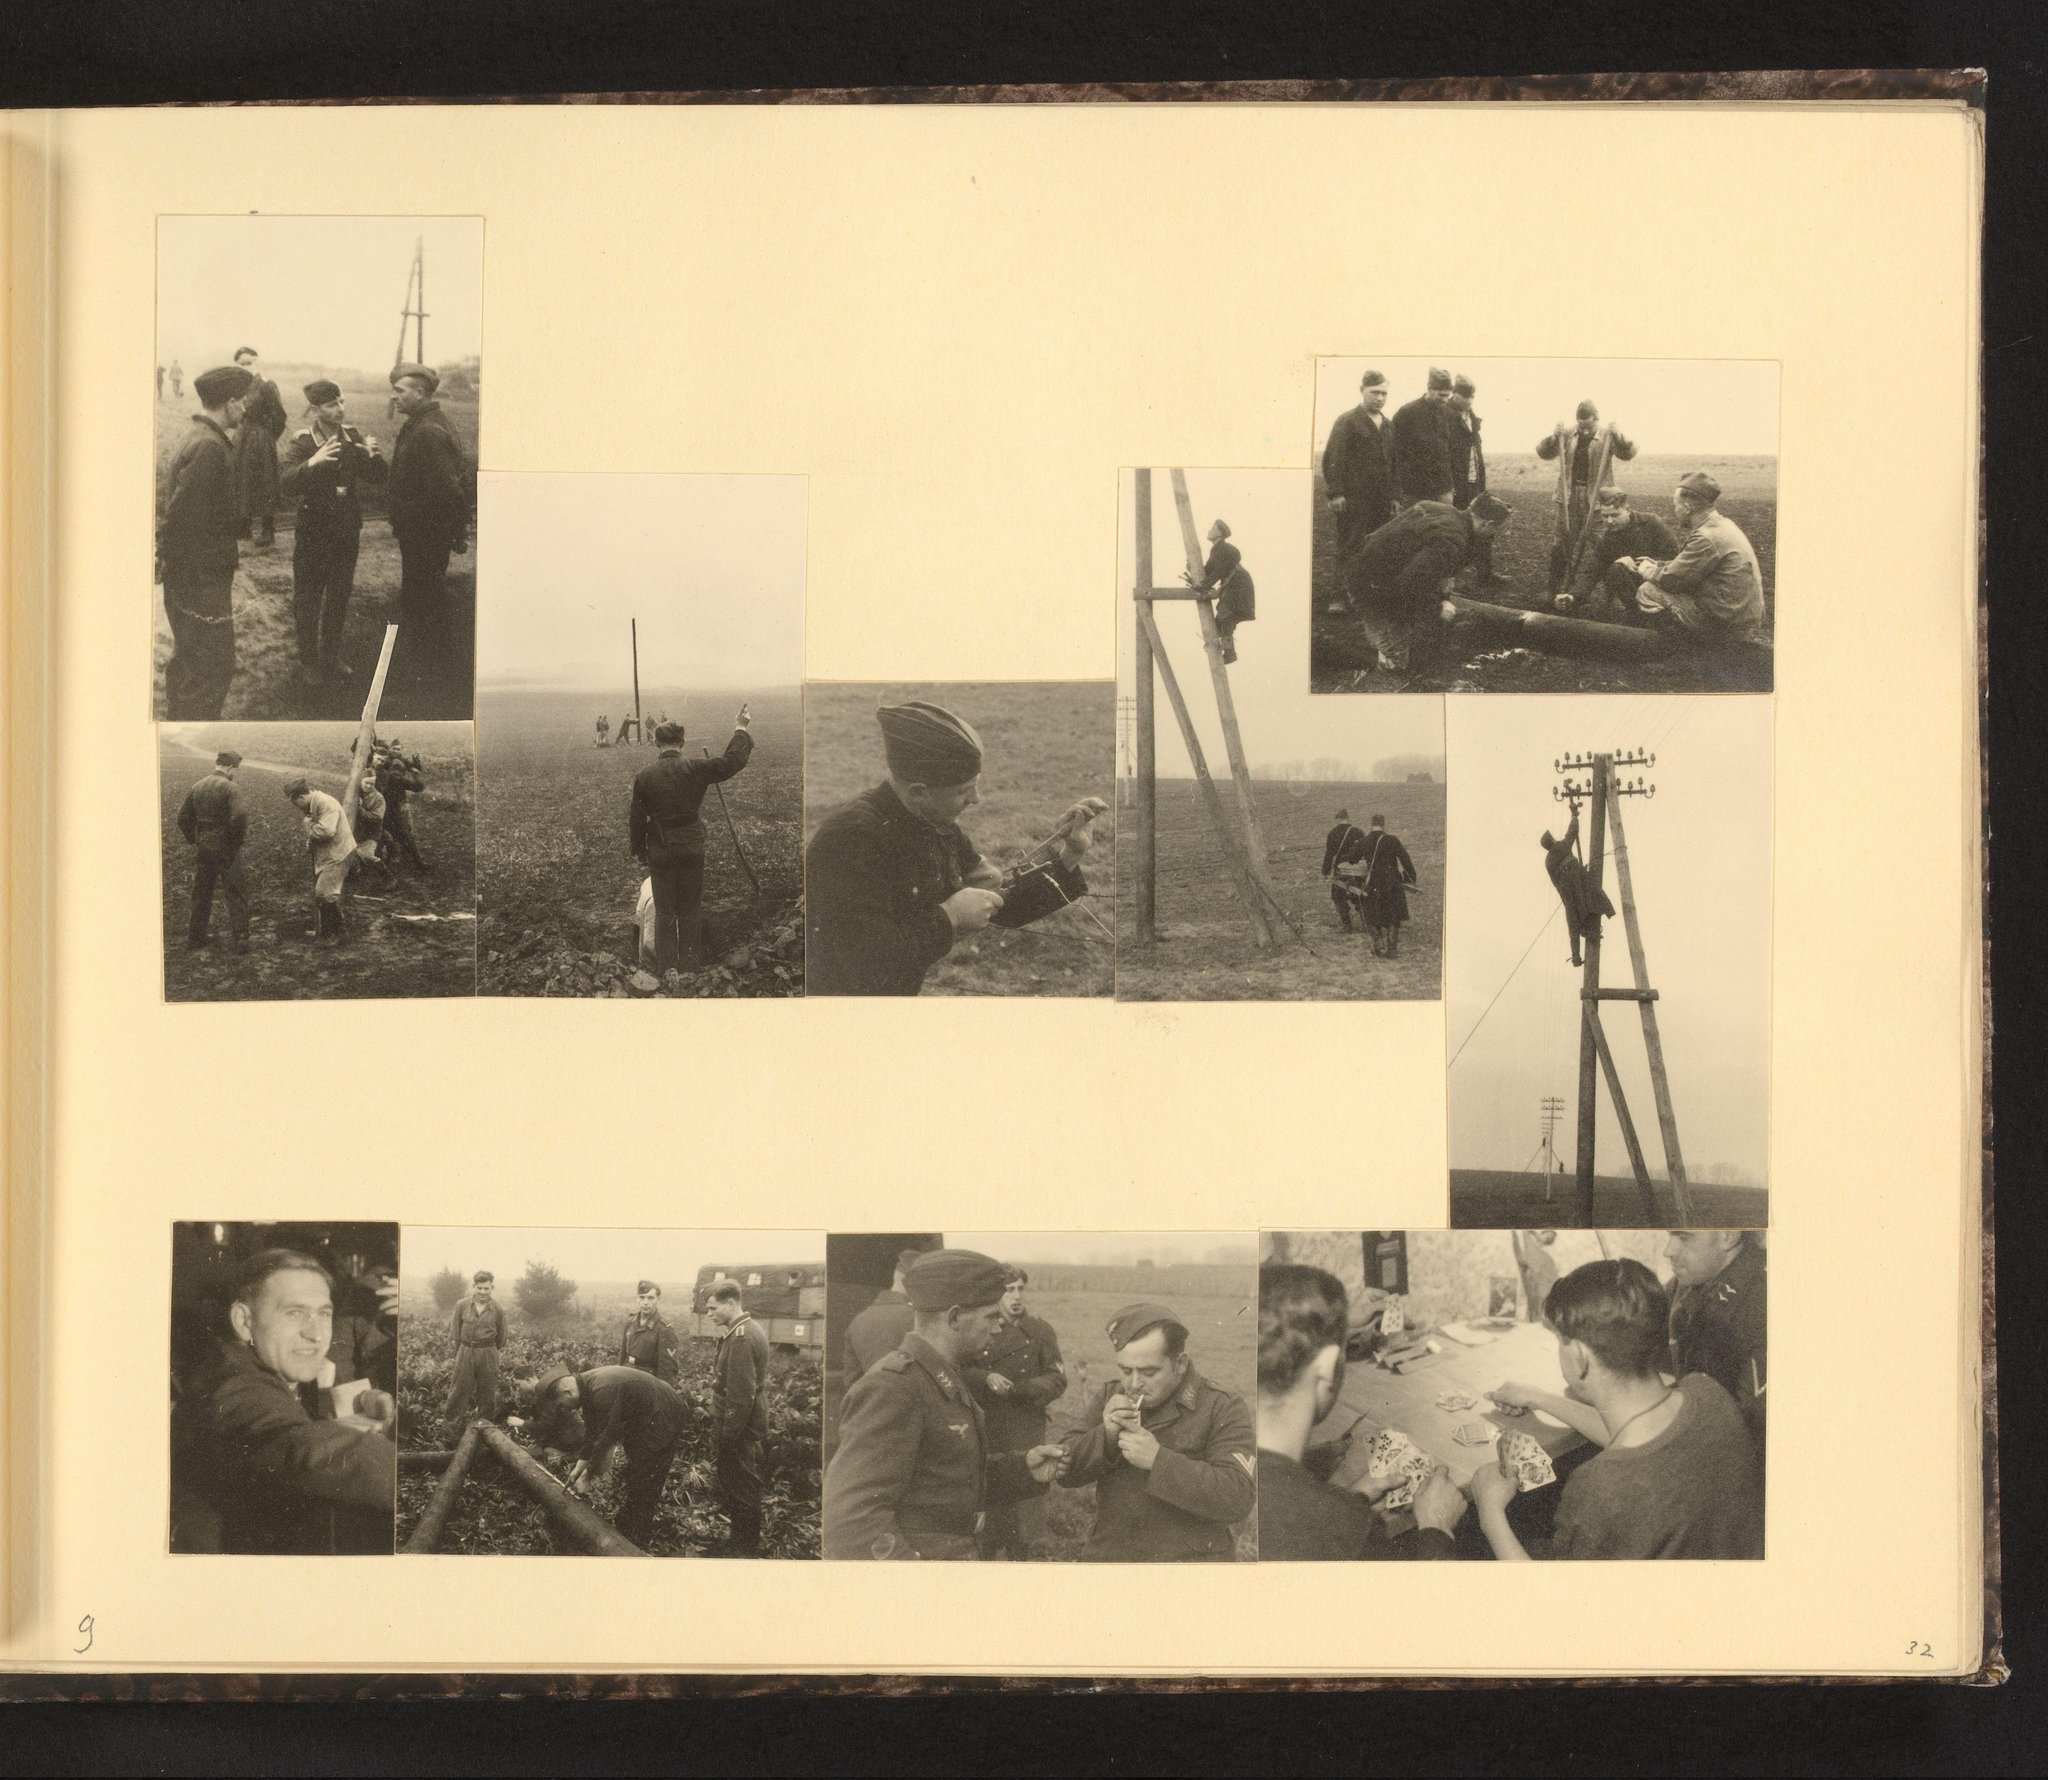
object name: photograph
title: Kabels trekken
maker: Anonymous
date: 1942-1943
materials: cardboard, photographic support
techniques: gelatin silver print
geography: belgium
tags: communication (military), netherlands, belgium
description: Albumblad met een collage van elf versneden foto's van het trekken van kabels voor de telecommunicatie, in België. Onderdeel van het fotoalbum van de Luftnachrichten-Regiment 211,1942-1943.